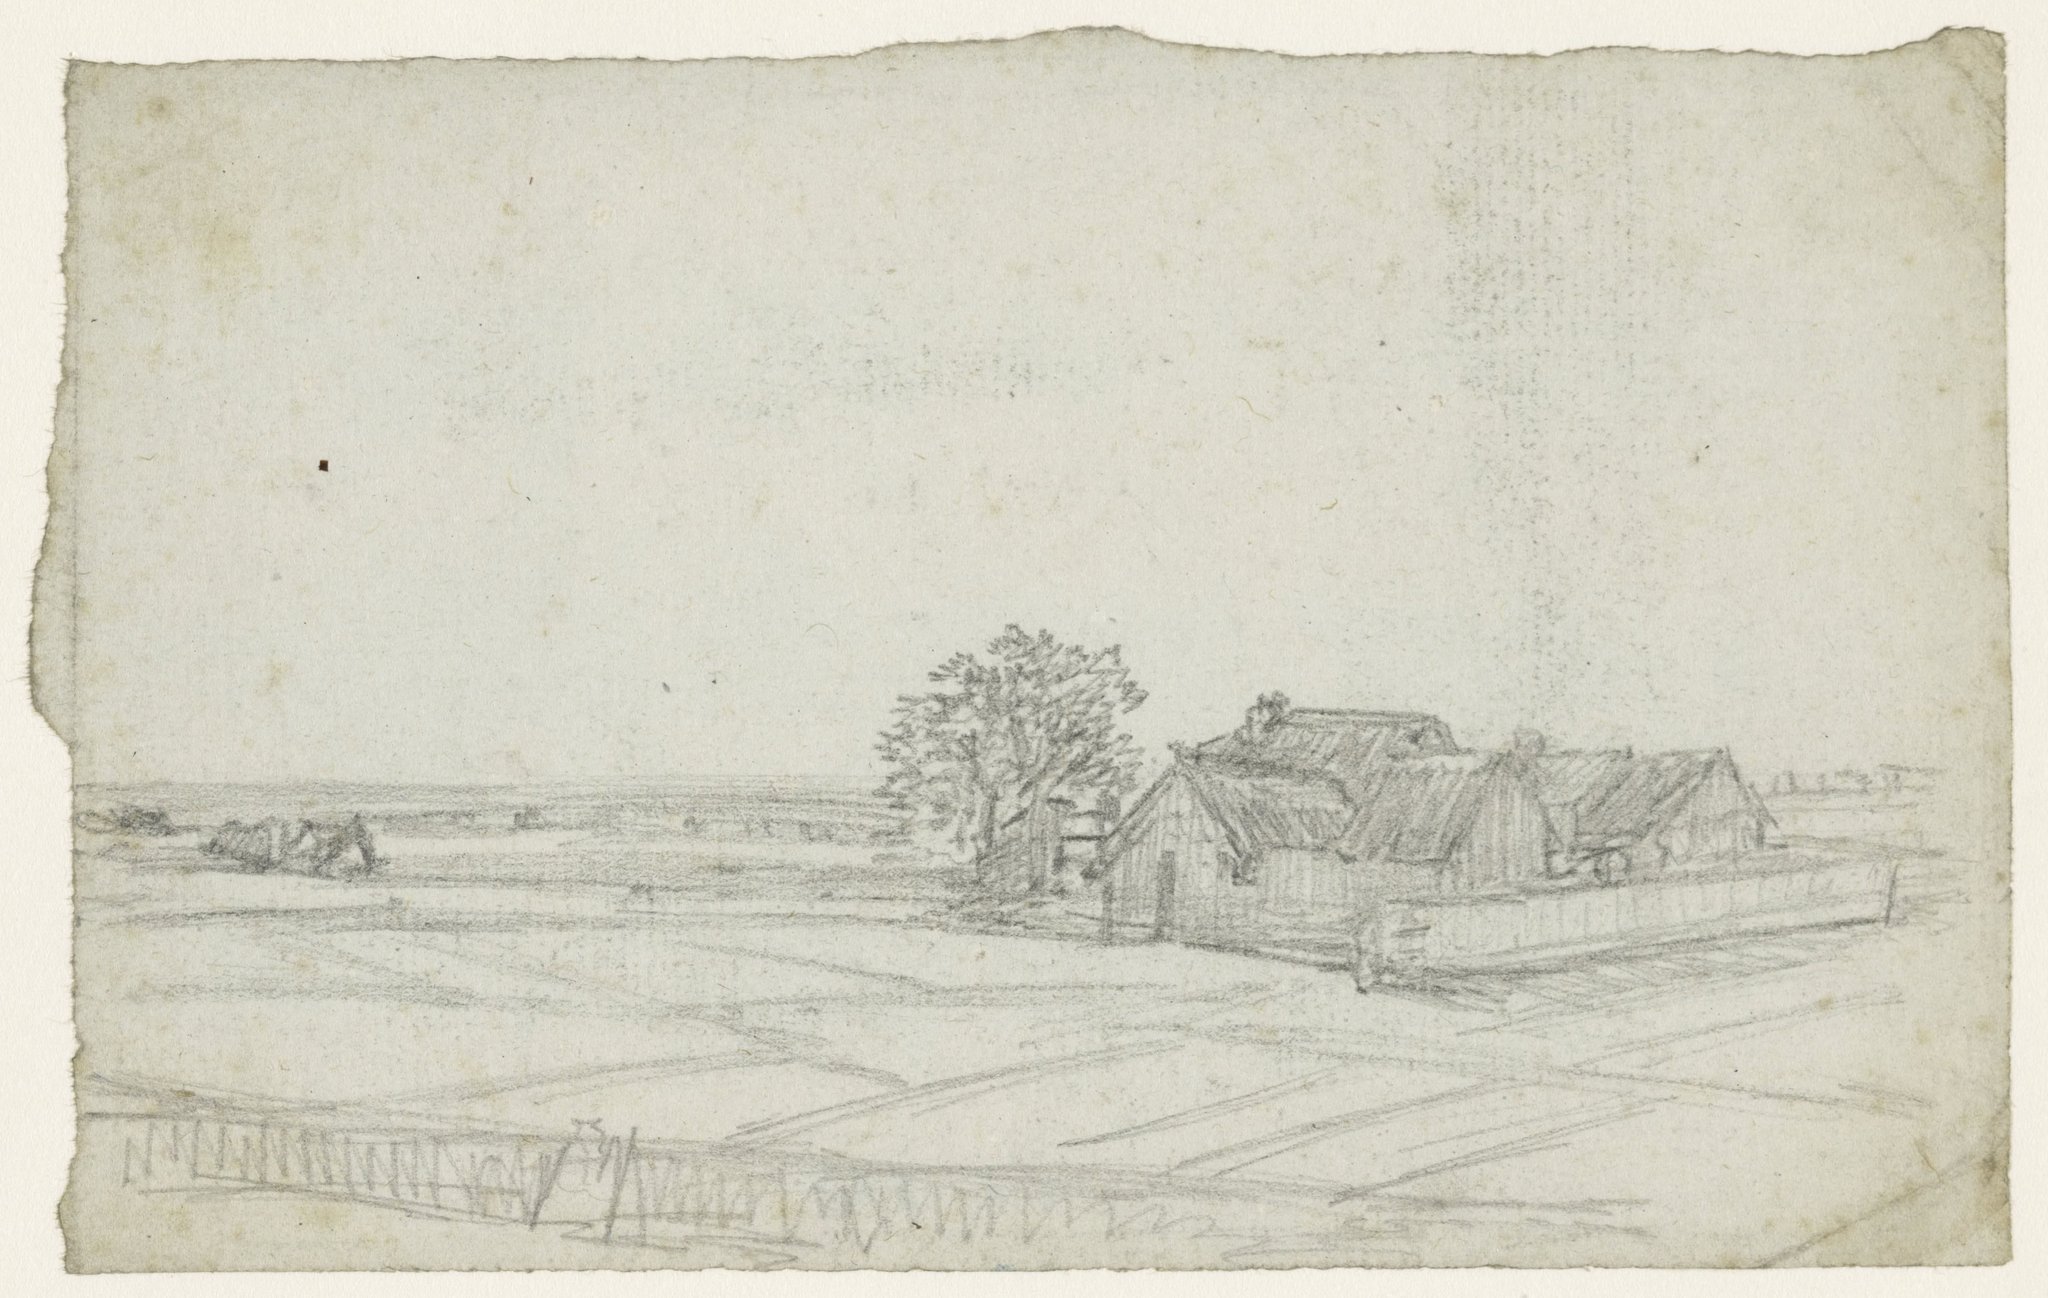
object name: drawing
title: Groep van boerderijen in akkers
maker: georges michel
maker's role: draughtsman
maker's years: 1763-1843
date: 1773-1843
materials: paper, pencil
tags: farm or solitary house in landscape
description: Een van 120 tekeningen, afkomstig uit een 19e eeuws album met tekeningen van Georges Michel.